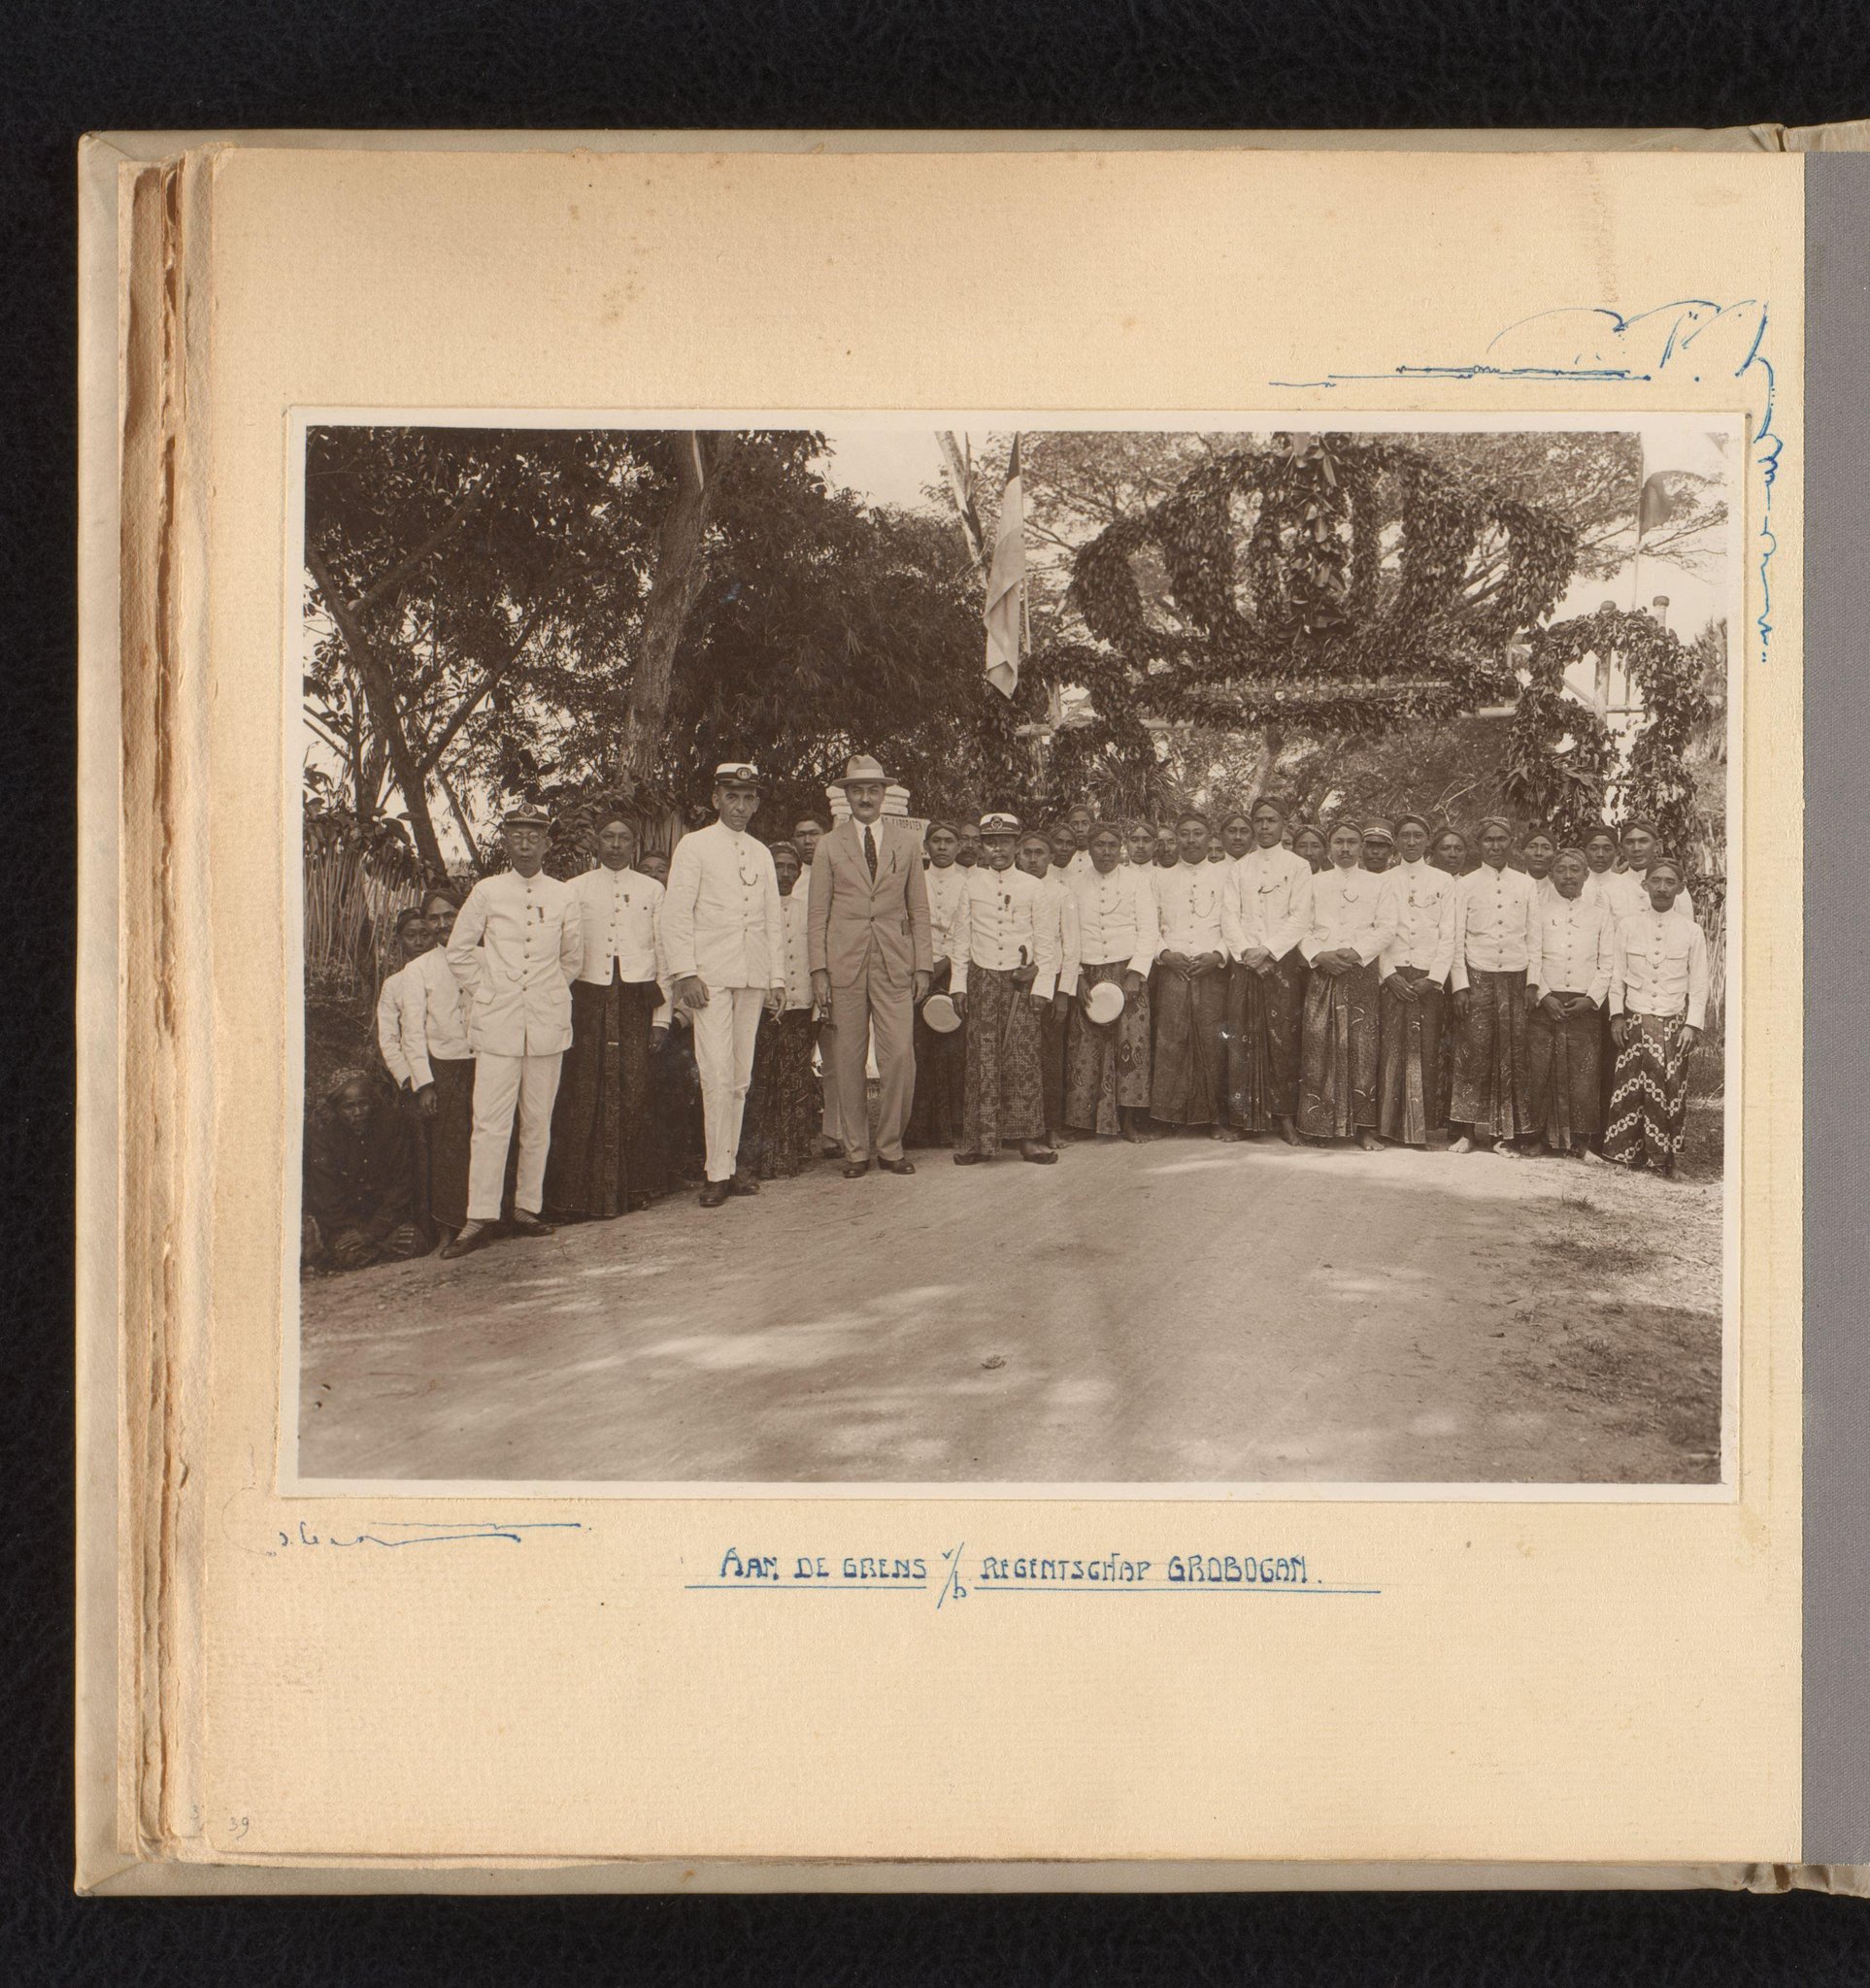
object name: album leaf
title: Groepsfoto met Habbema en staf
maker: Anonymous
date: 1910-1928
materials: paper, photographic support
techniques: drawing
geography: grobogan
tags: colonial government, anonymous historical persons portrayed in a group, in a group-portrait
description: Albumblad met een groepsfoto met Habbema omringd door leden van zijn staf in Grobogan. Het blad is versierd met randwerk om de foto's. Onderdeel van het fotoalbum aangeboden aan J. Habbema door het Binnenlandsch Bestuur Corps van het Regentschap Grobogan, bij het beëindigen van zijn bestuur over het Regentschap, waarschijnlijk in 1928.